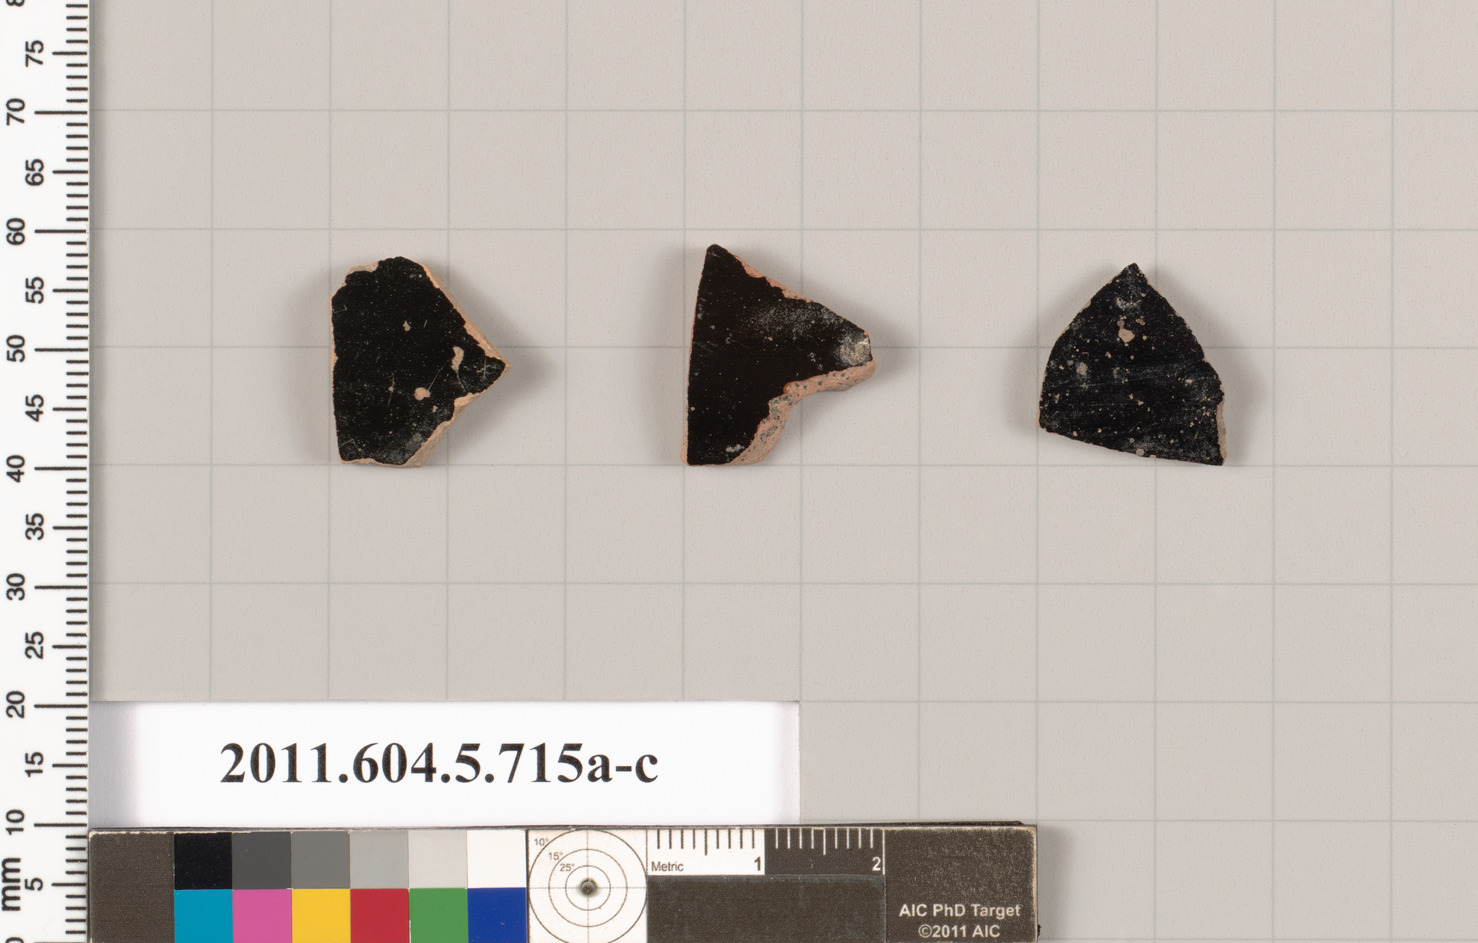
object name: kylix fragment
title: Terracotta fragments of kylikes (drinking cups)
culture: greek, attic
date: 600-401 BCE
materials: terracotta